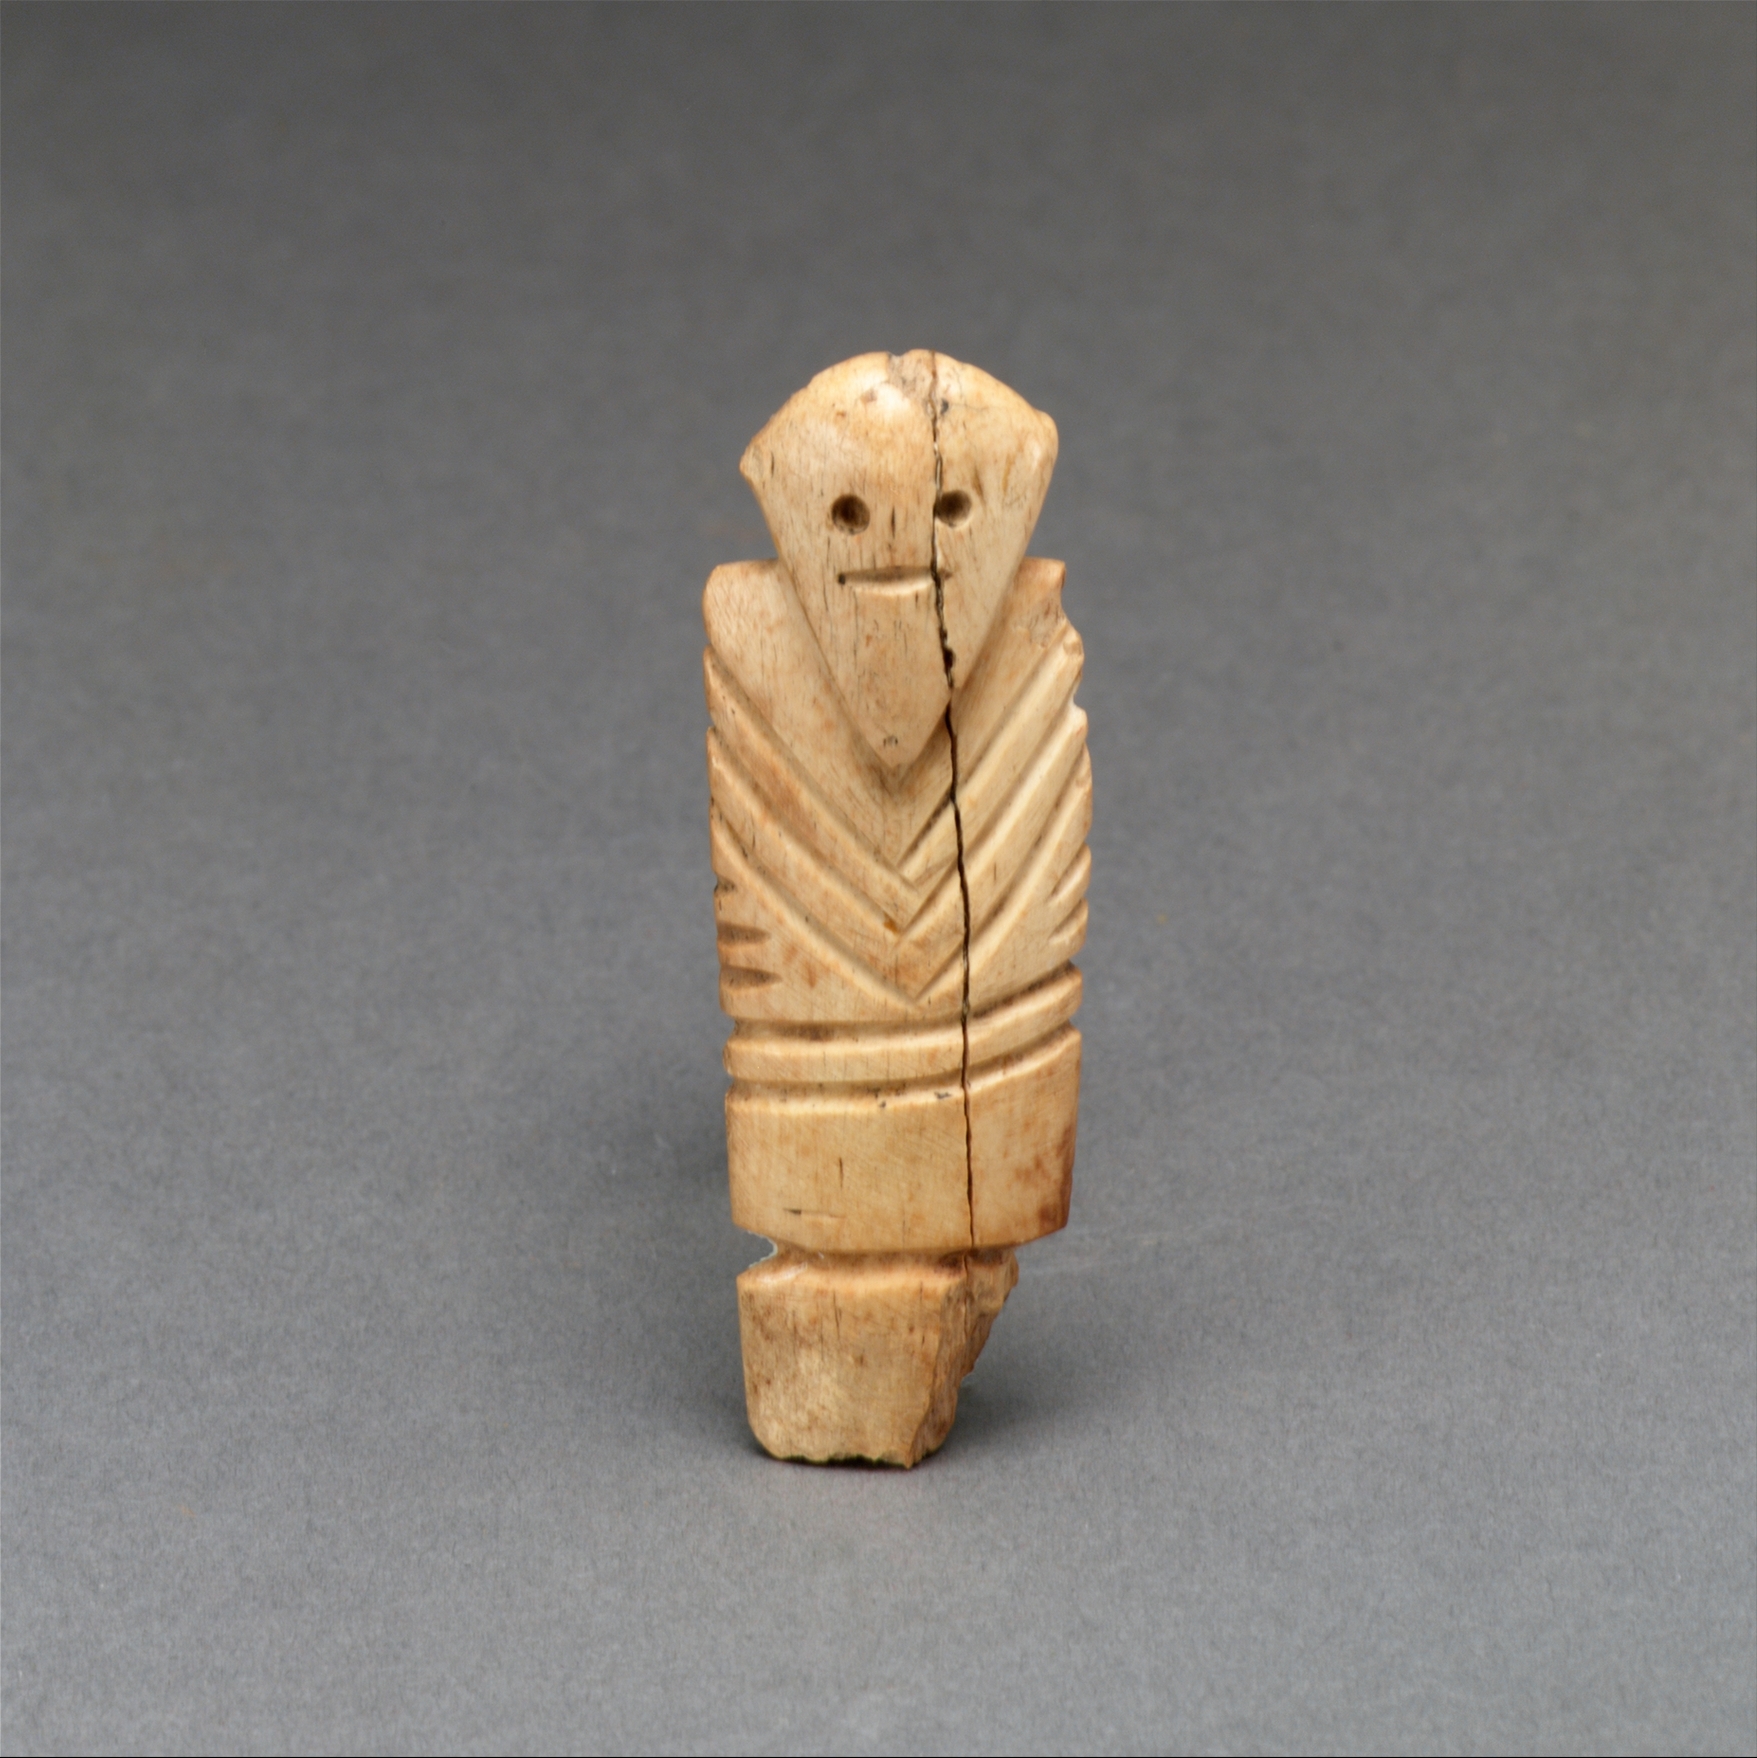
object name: statuette, standing man, beard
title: Figurine of a man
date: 3650-3450 BCE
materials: ivory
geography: egypt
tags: men